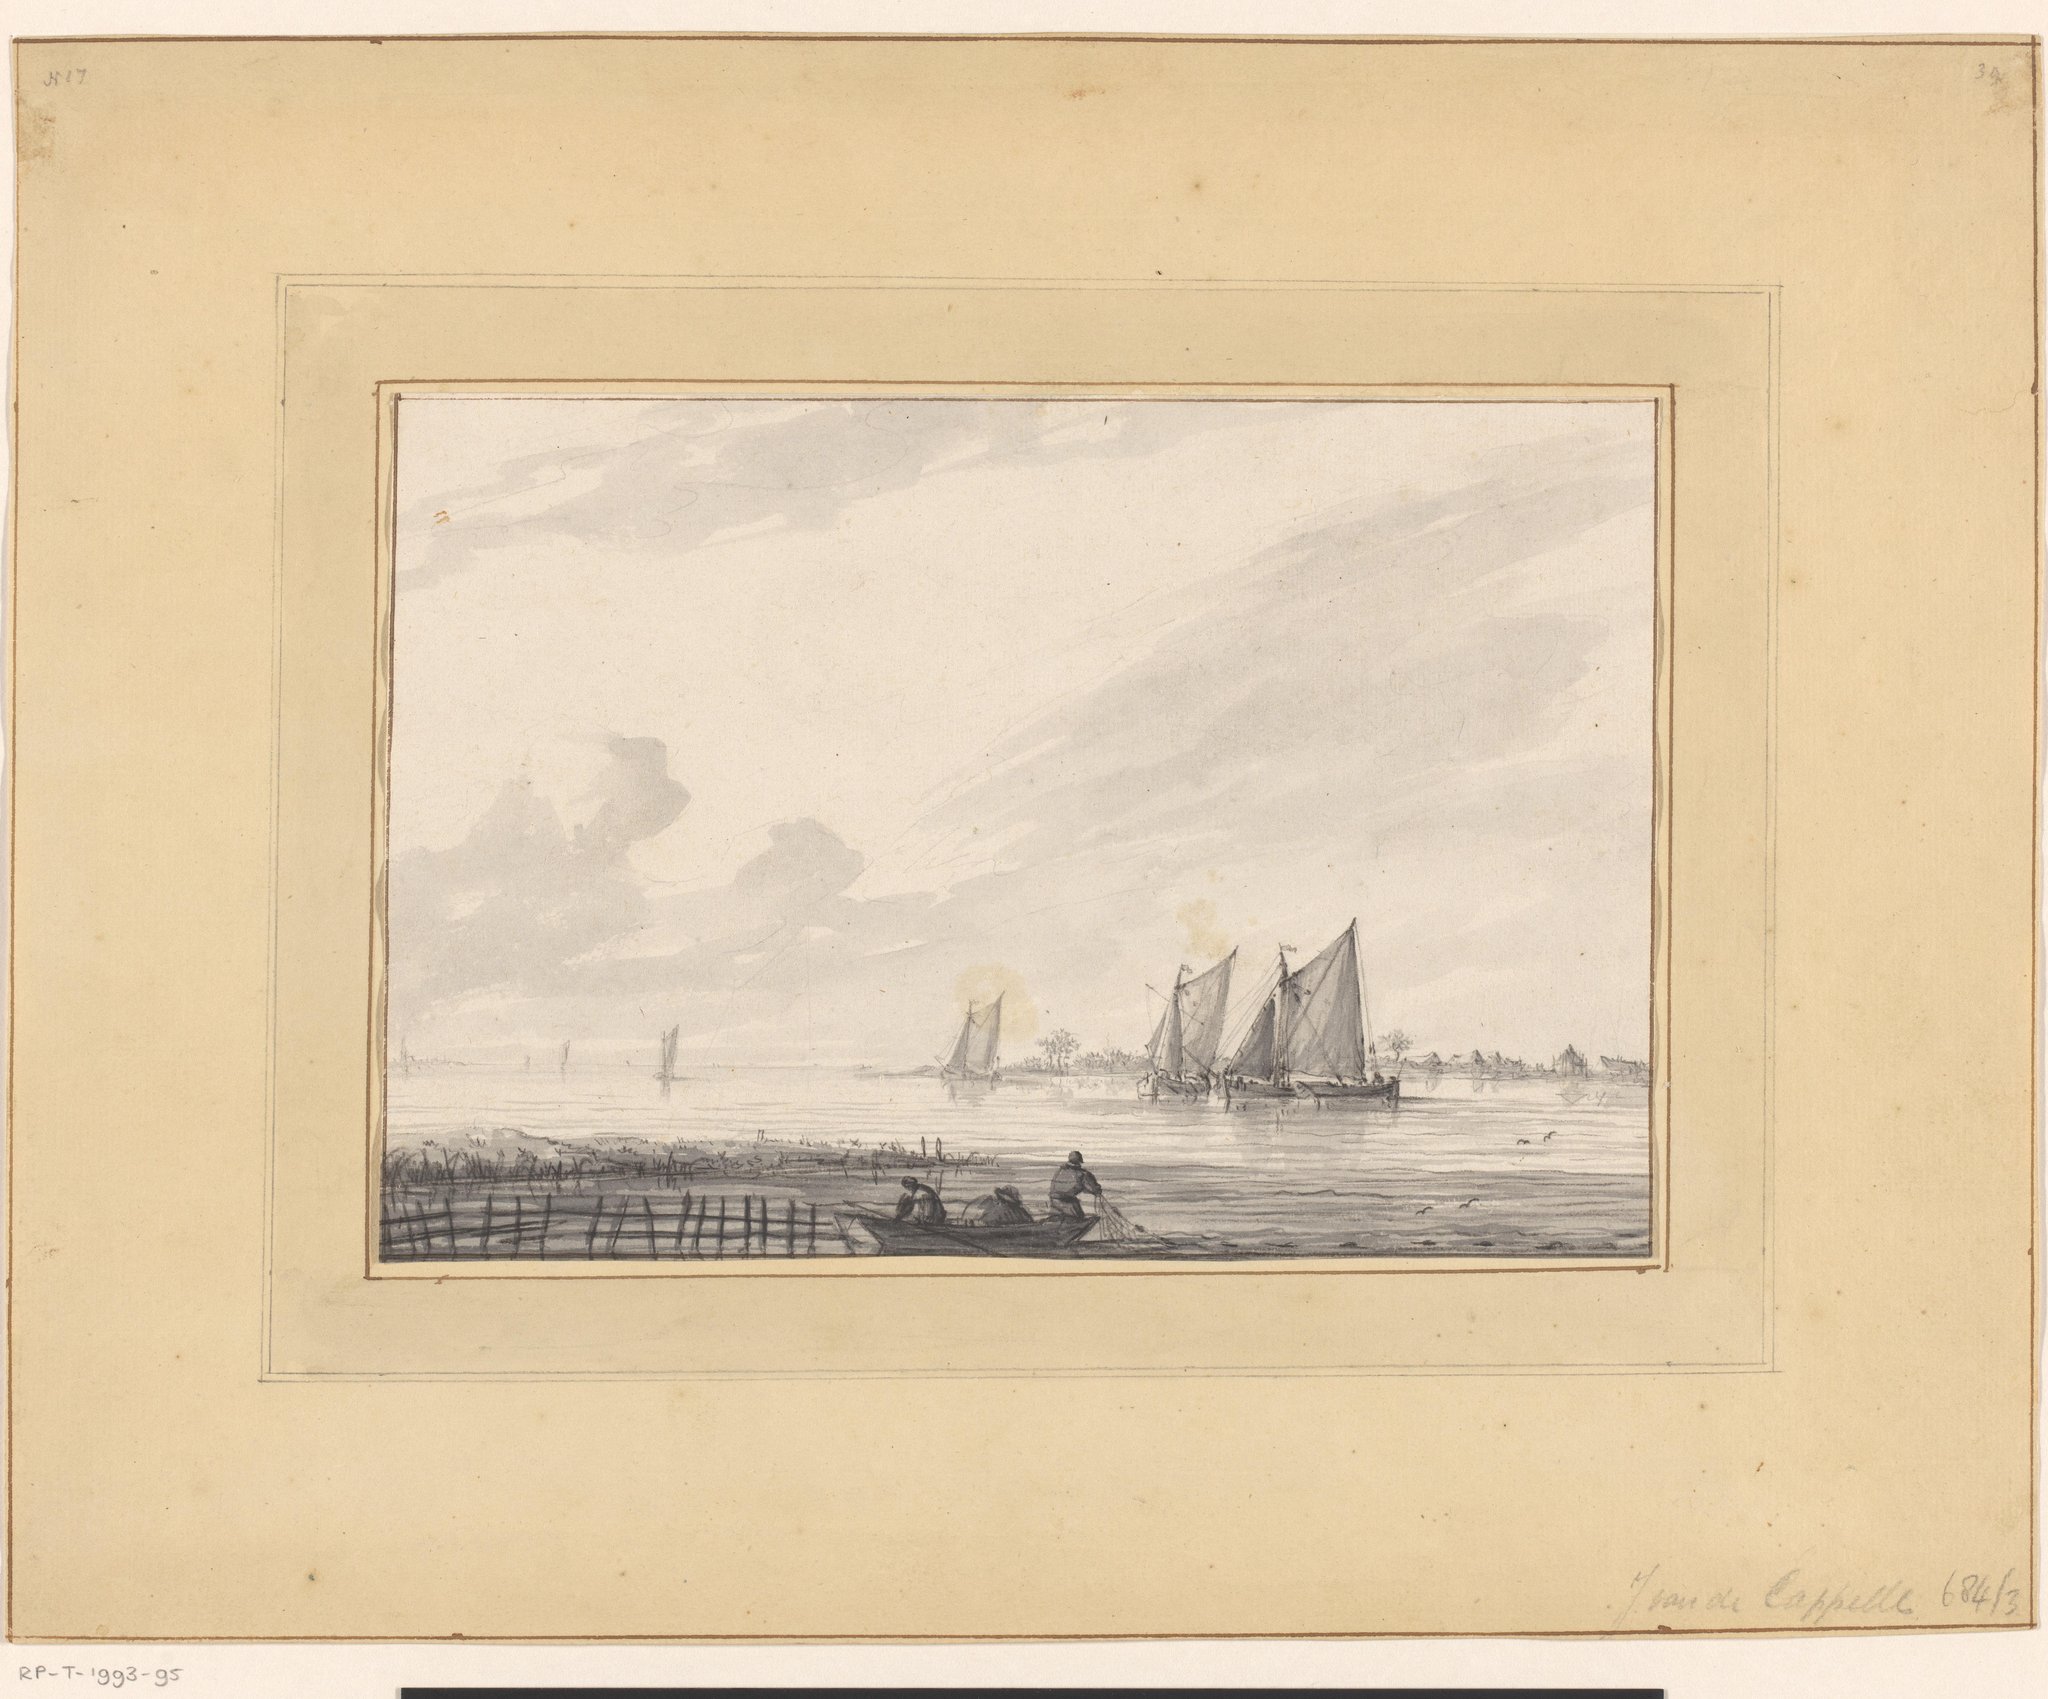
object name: drawing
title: Schepen in een riviermonding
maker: hendrick jacobsz. dubbels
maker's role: draughtsman, painter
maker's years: 1621-1707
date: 1631-1707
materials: graphite, ink, paper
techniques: brush, pen